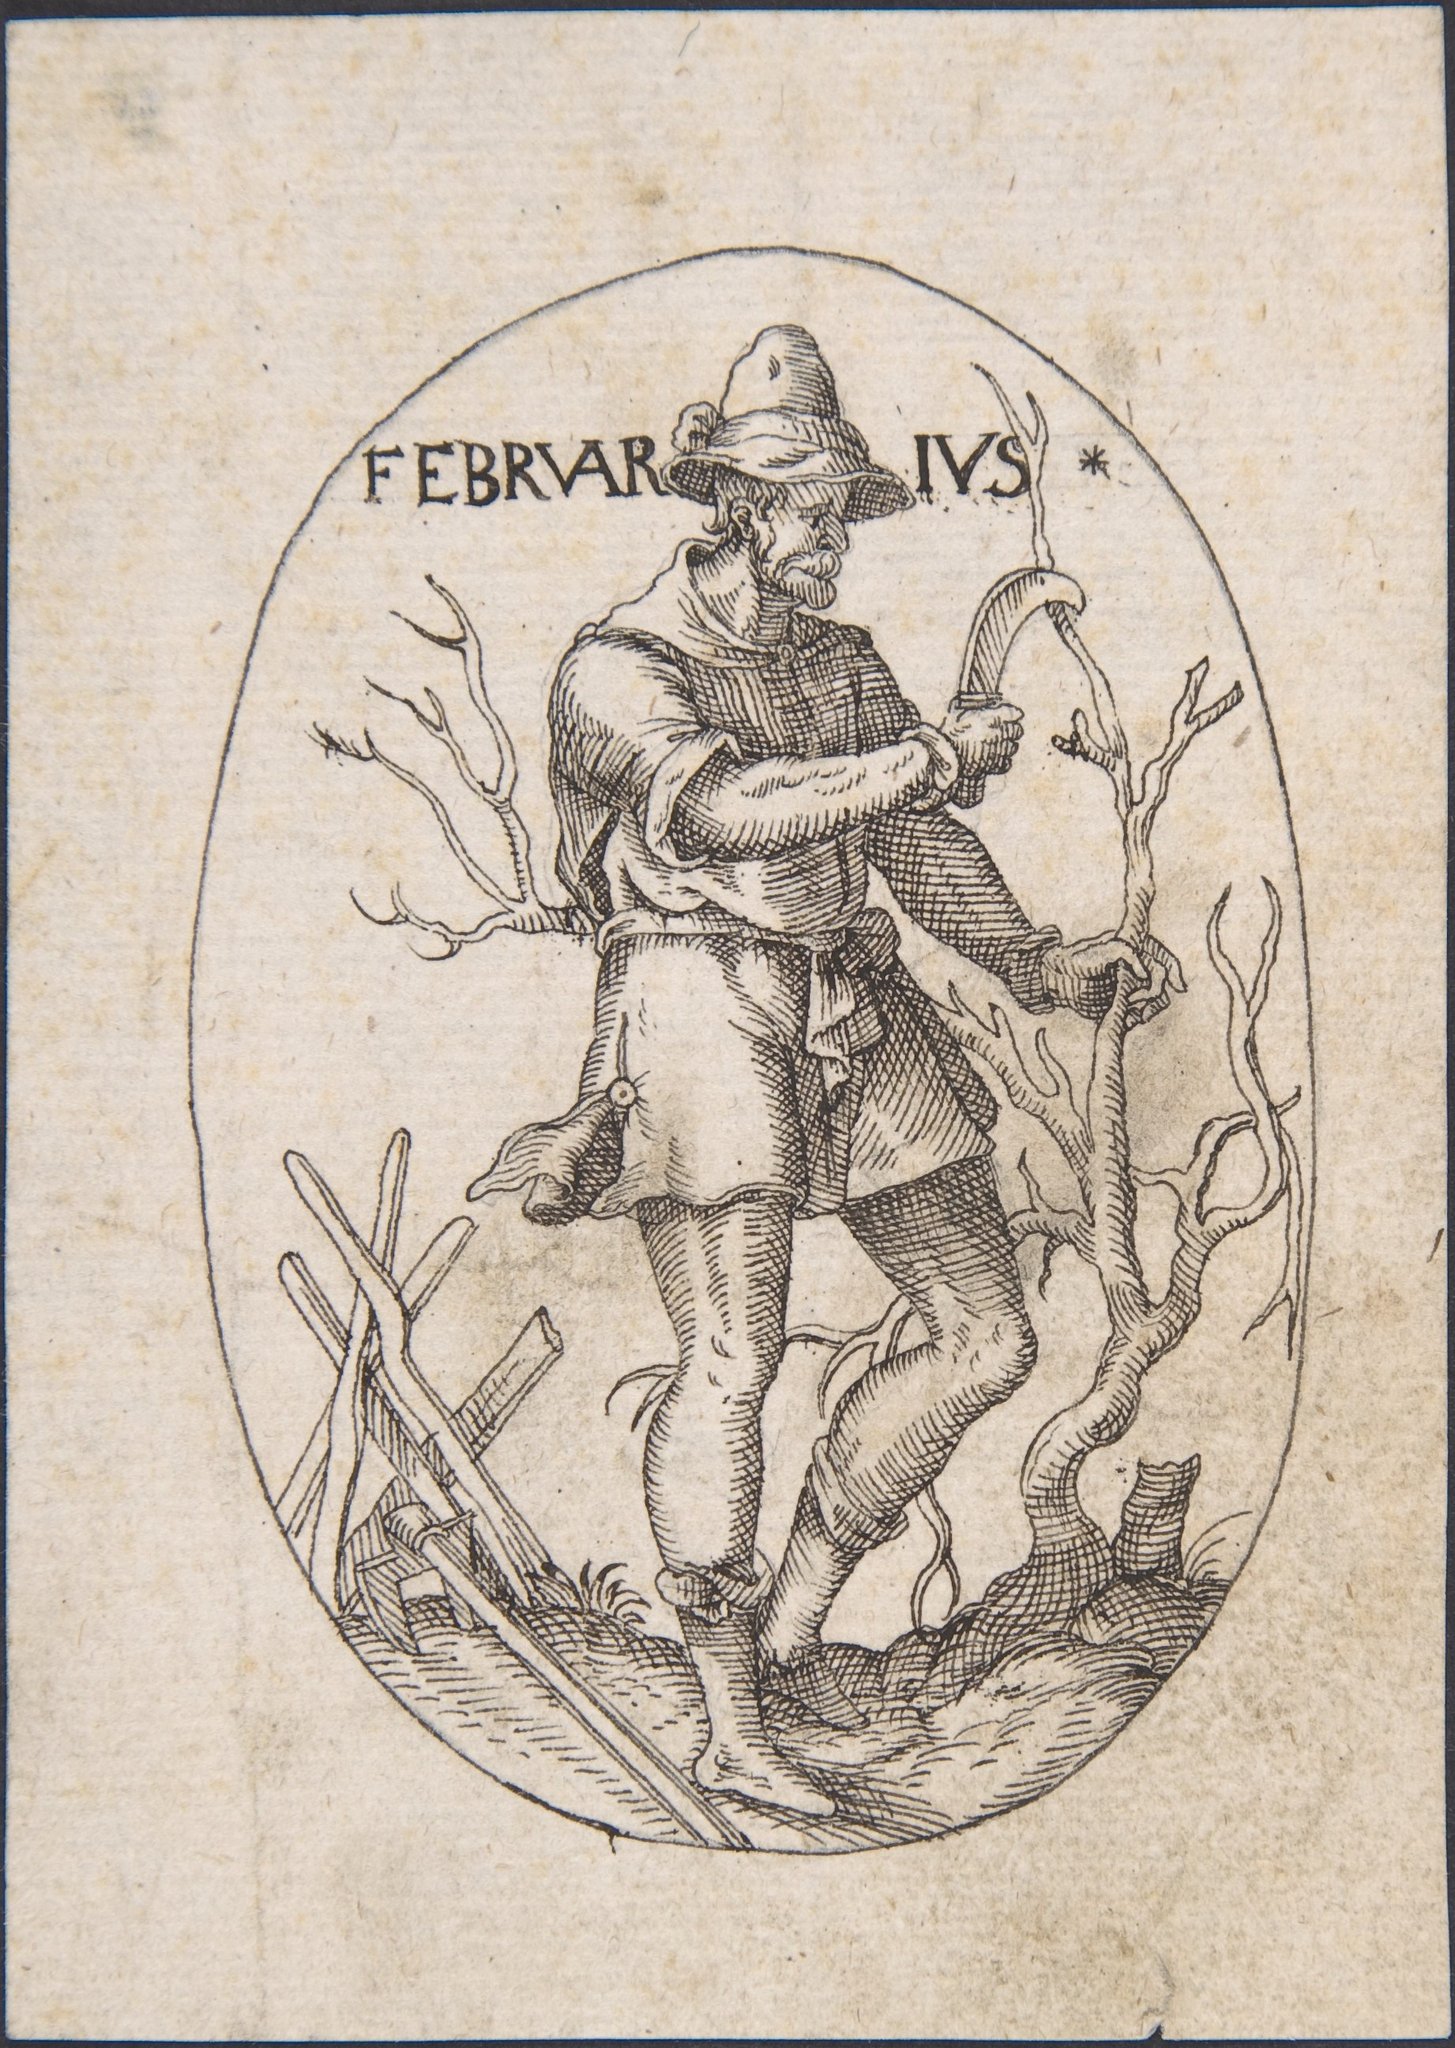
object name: drawing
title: The Month of February: Man Pruning a Tree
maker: erasmus hornick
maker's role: artist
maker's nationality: netherlandish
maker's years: 1501-1583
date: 1501-1600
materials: chalk, ink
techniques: pen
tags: men,trees,working